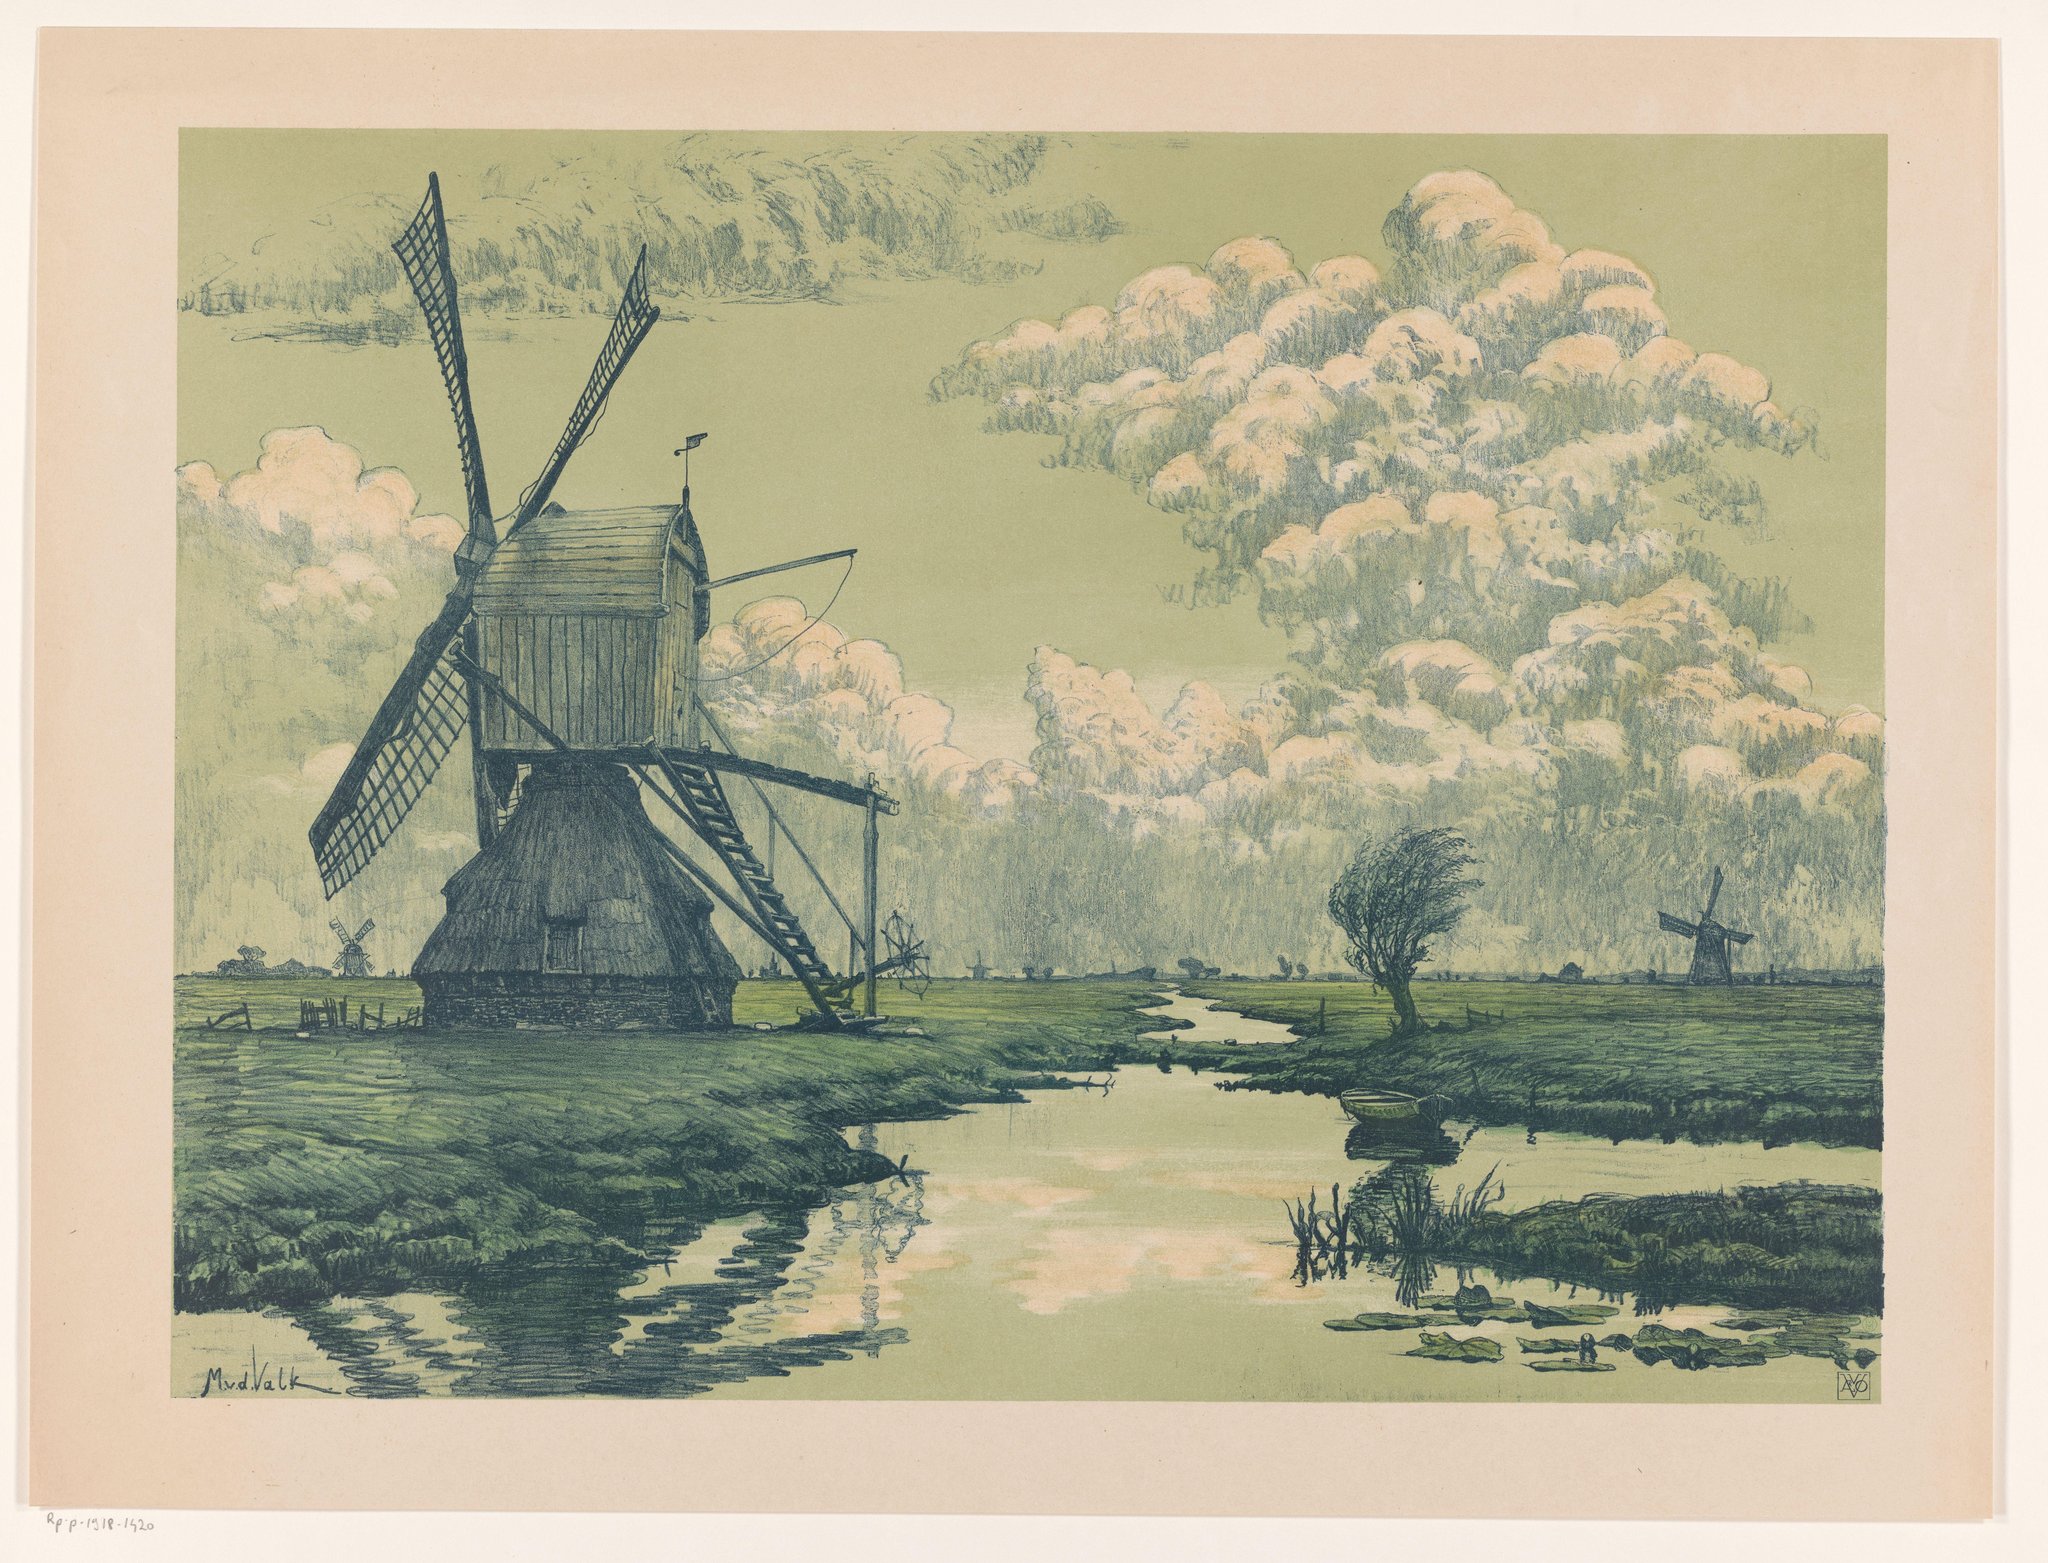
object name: print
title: Polderlandschap met molens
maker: maurits van der valk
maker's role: draughtsman, print maker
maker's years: 1857-1935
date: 1908-1918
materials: paper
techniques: lithograph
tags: windmill in landscape, polder, reclaimed land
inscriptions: collector's mark: Lugt 2233, collector's mark: Lugt 2228